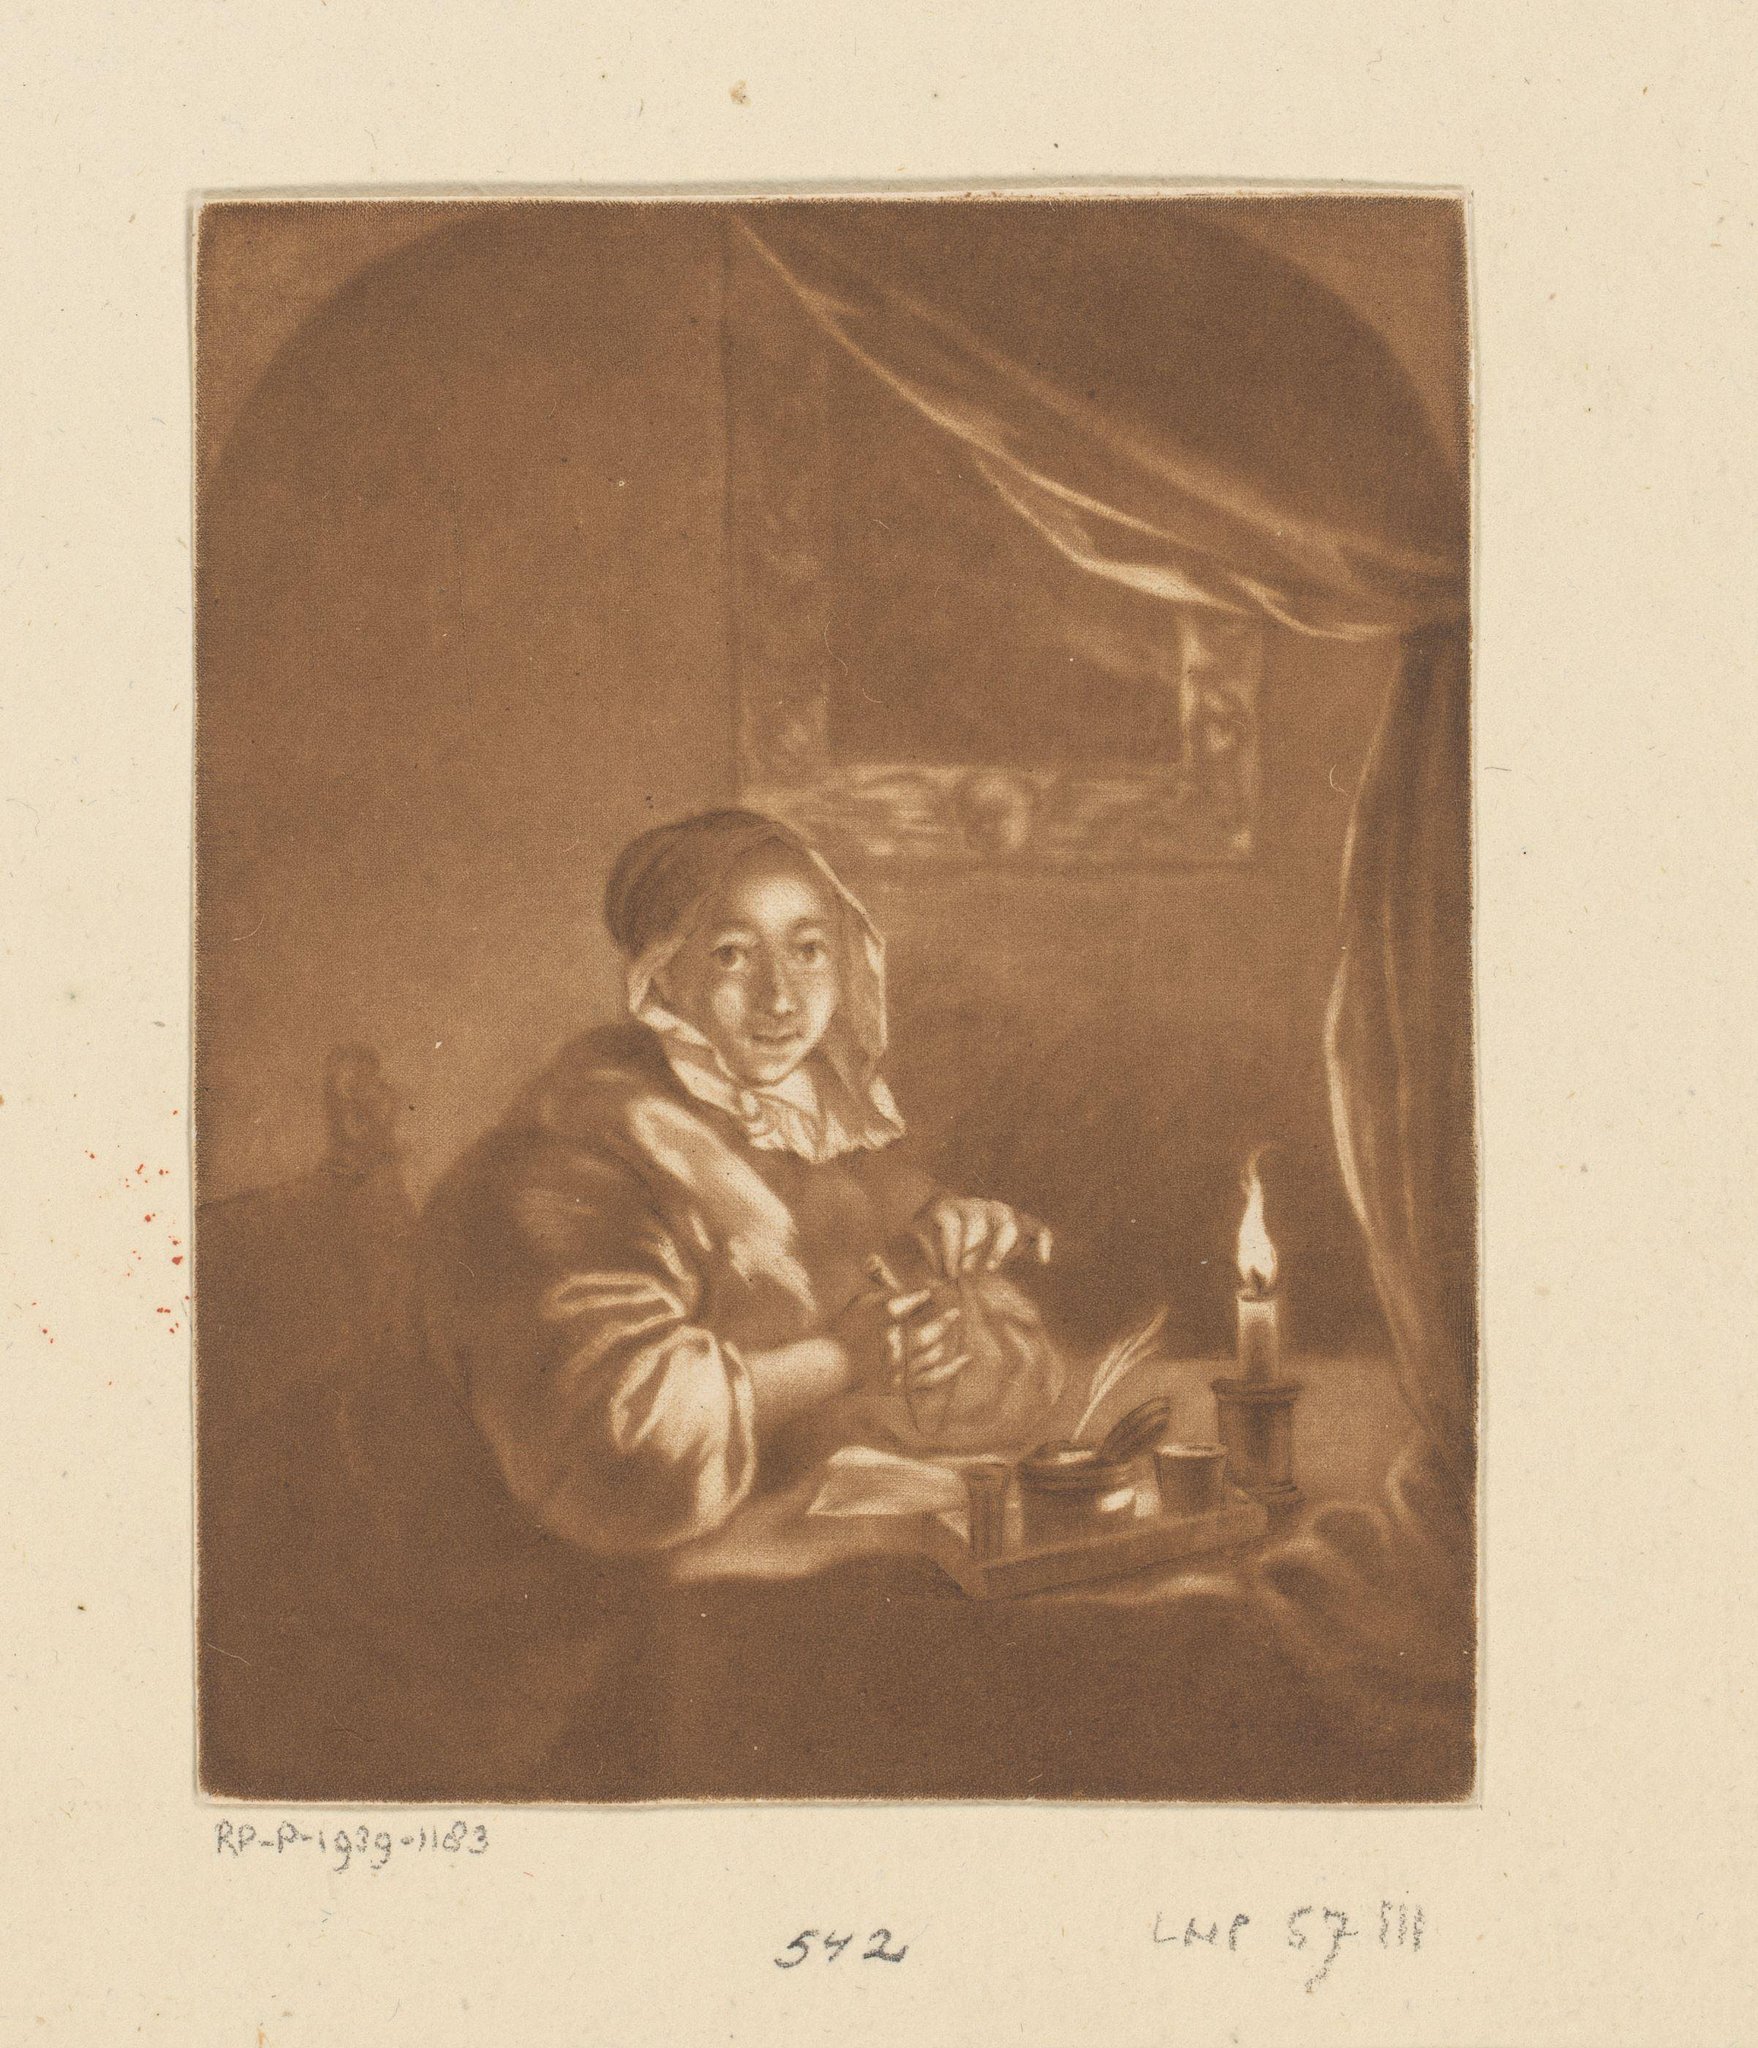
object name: print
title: Dame bij kaarslicht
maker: cornelis ploos van amstel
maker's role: draughtsman, print maker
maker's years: 1726-1798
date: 1736-1798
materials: paper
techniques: etching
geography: amsterdam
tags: candle, (other forms of) needlework, e.g.: crocheting, knitting, embroidering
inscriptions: collector's mark: ‘RIJKS / MUSM’, collector's mark: Lugt 2725, inscription: ‘Geoffreerd aan mynen Kunstlievende Oom de Heer H Charlon CPvA JC// G. Netscher del/ CPloos v Amstel JC Fecit’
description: Een vrouw, zittend aan tafel met een breiwerk in de handen, bij kaarslicht. De prent ligt los in een album, zie blad 57.